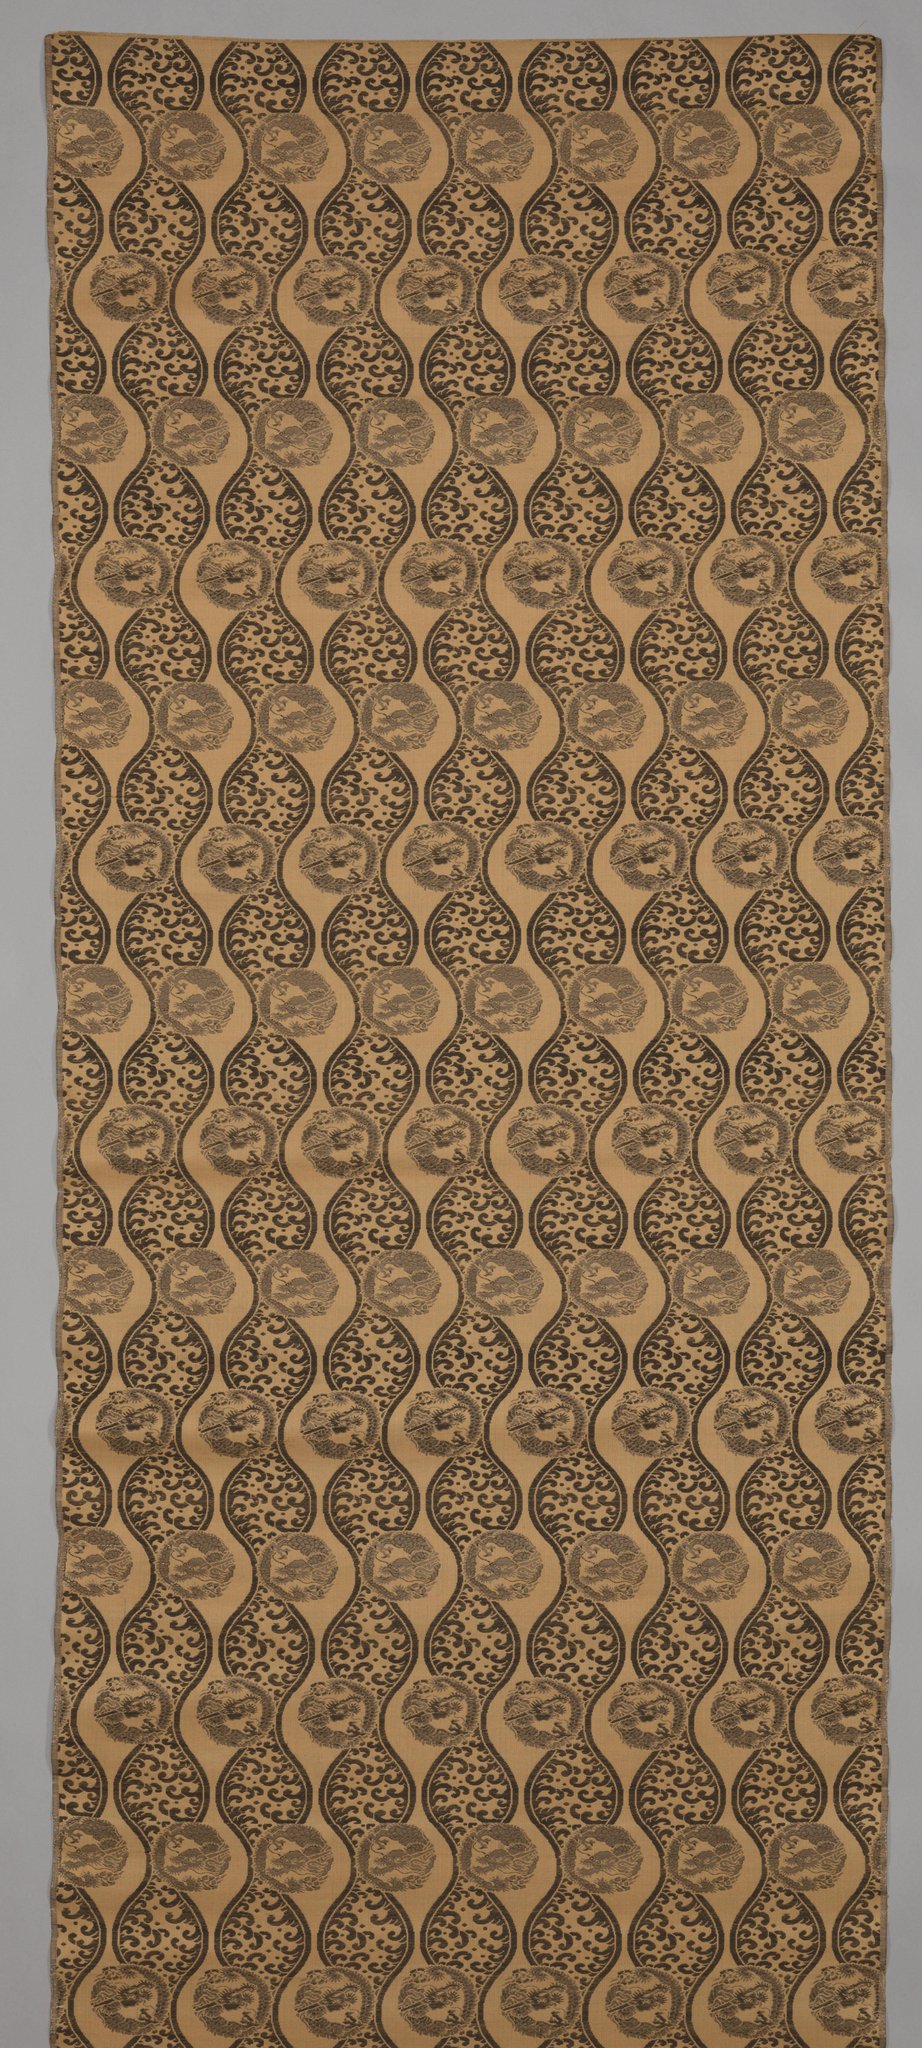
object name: baan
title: Baan zijdedamast met een dessin van omhoog slingerende banden, per paar gevuld met sikkelvormen "waaroverheen" een dessin van cirkels opgebouwd uit semi-abstract ornament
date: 1900-1920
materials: silk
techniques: damask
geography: japan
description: Baan zijdedamast met een dessin van omhoog slingerende banden, per paar gevuld met sikkelvormen in bruin tegen een goudgeel fond "waaroverheen" een dessin van cirkels opgebouwd uit semi-abstract ornament in beige. Oosterse textiel.